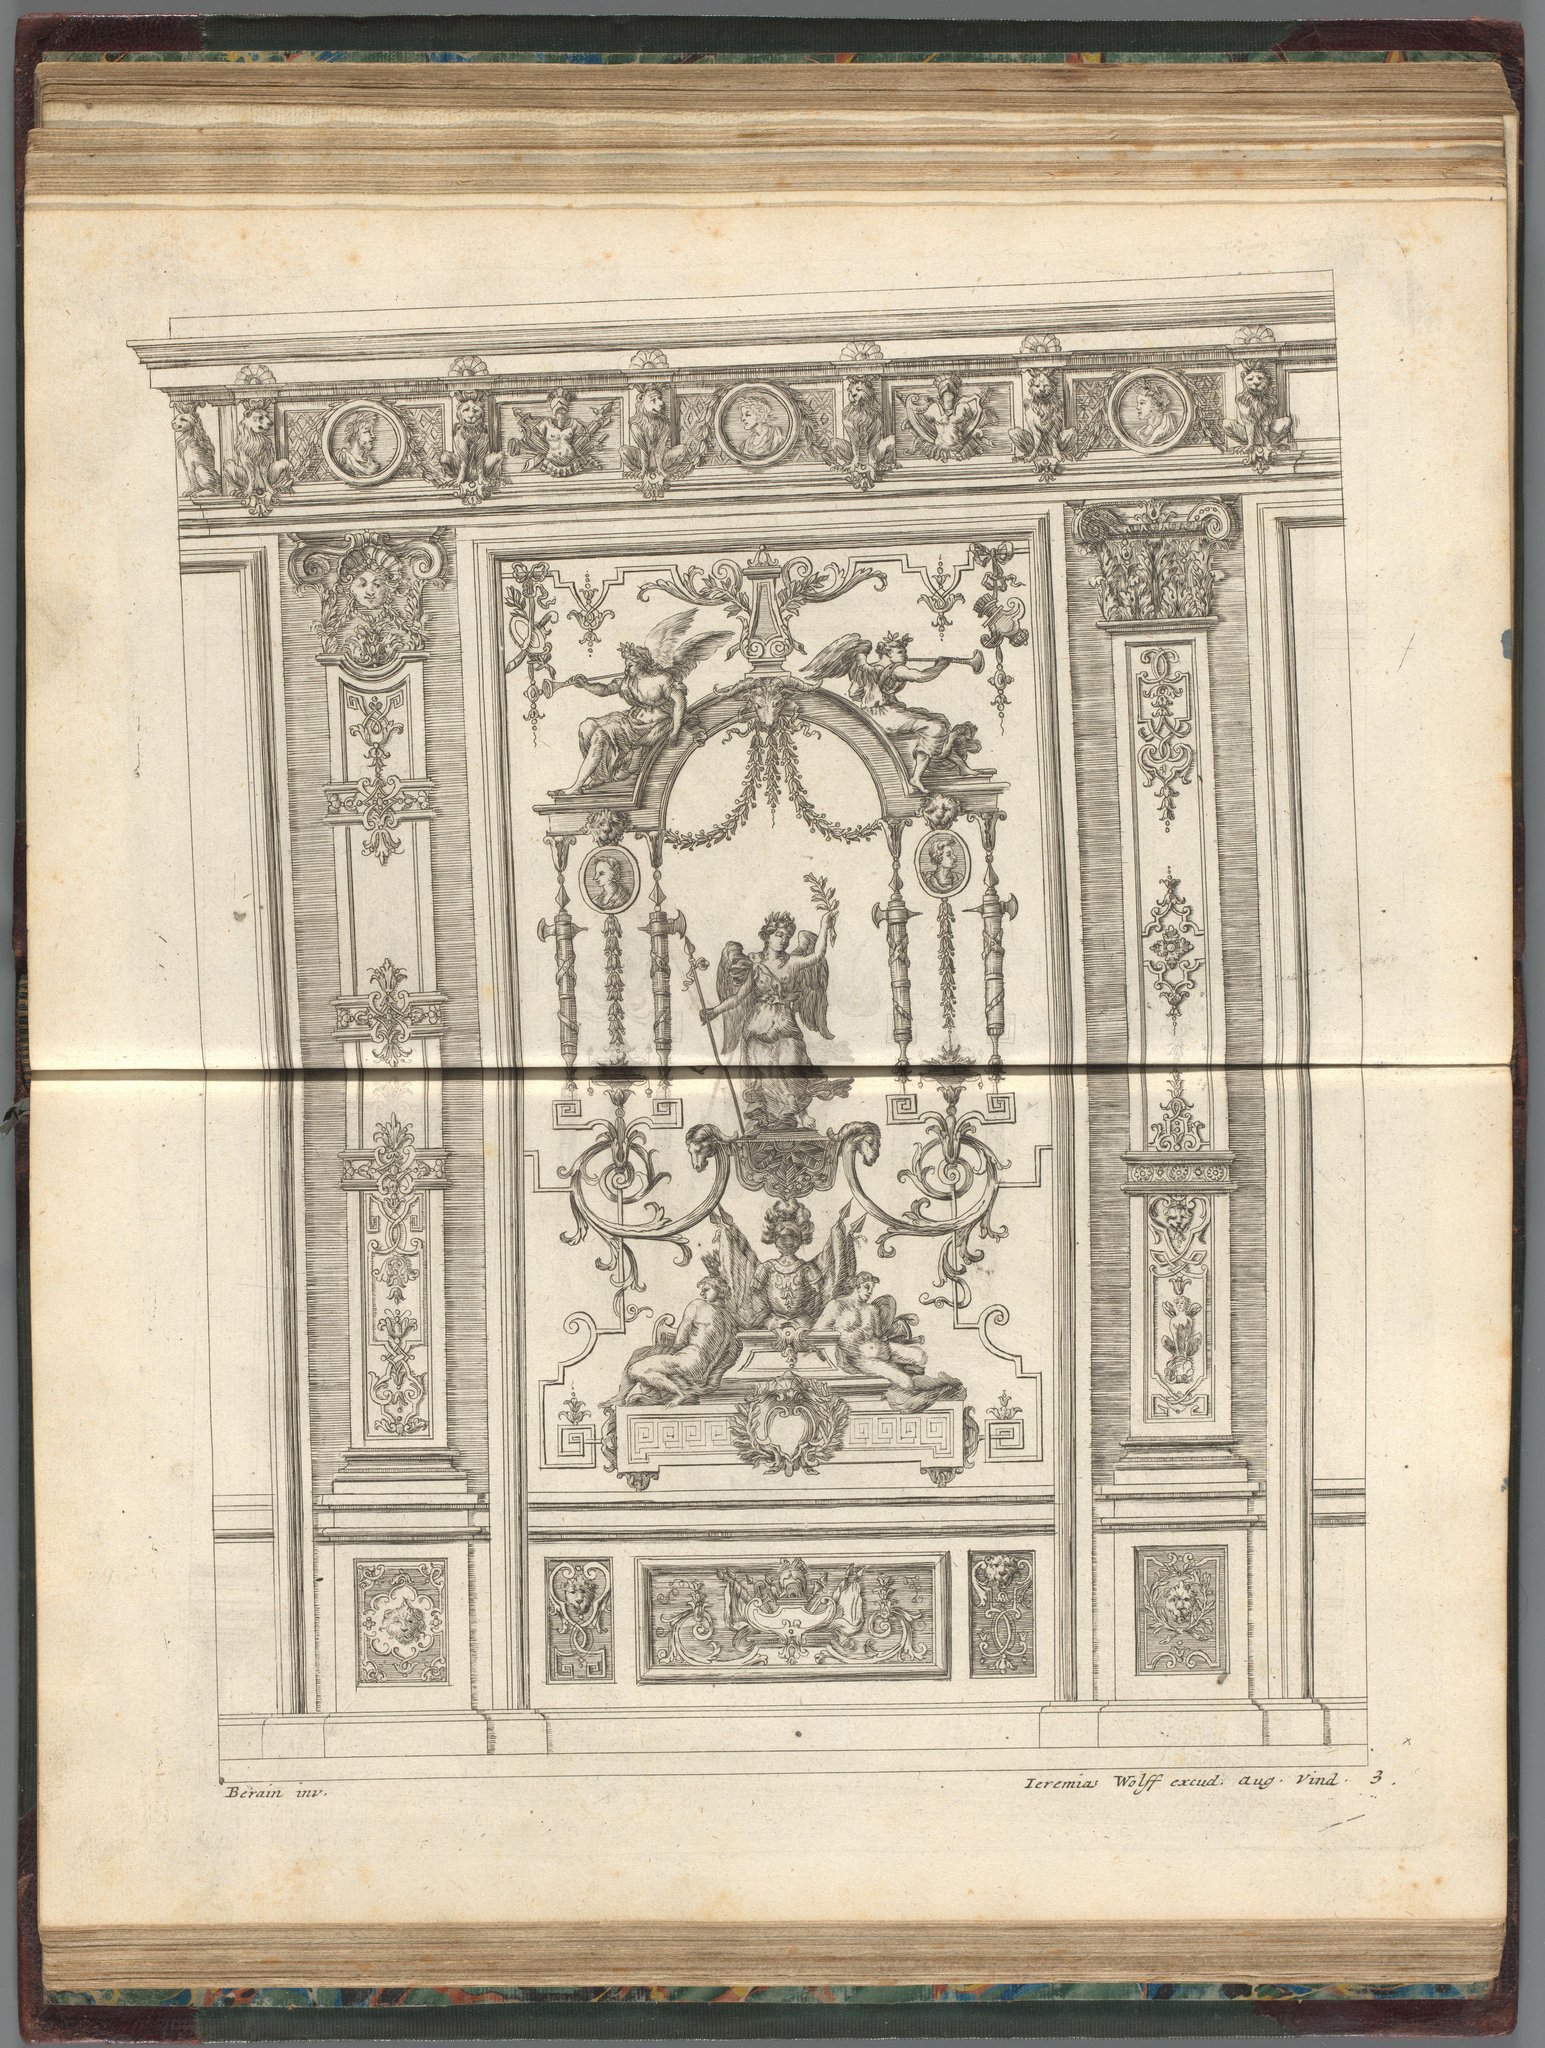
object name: album leaf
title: Paneel met Victoria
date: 1686-1724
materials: paper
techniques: etching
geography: augsburg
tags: ornaments ~ art, panelling, victoria as roman personification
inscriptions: signature: ‘Berain inv.’, signature: ‘Ieremias Wolff excud. Aug. Vind.’, number: ‘3.’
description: Wanddecoratie met een paneel met vlechtwerk geflankeerd door geornamenteerde pilasters. Op het paneel staat Victoria op een voetstuk met twee fasces aan weerszijden onder een arcade. Daaronder een harnas met vlaggen en twee naakte figuren op een tweede voetstuk. Aan de bovenzijde een bekroning met twee engelen blazend op bazuinen. Boven het paneel een fries met trofeeën, medaillons met portretten en leeuwen. Prent maakt deel uit van een album. Hoogstwaarschijnlijk gespiegelde kopie naar Frans origineel.